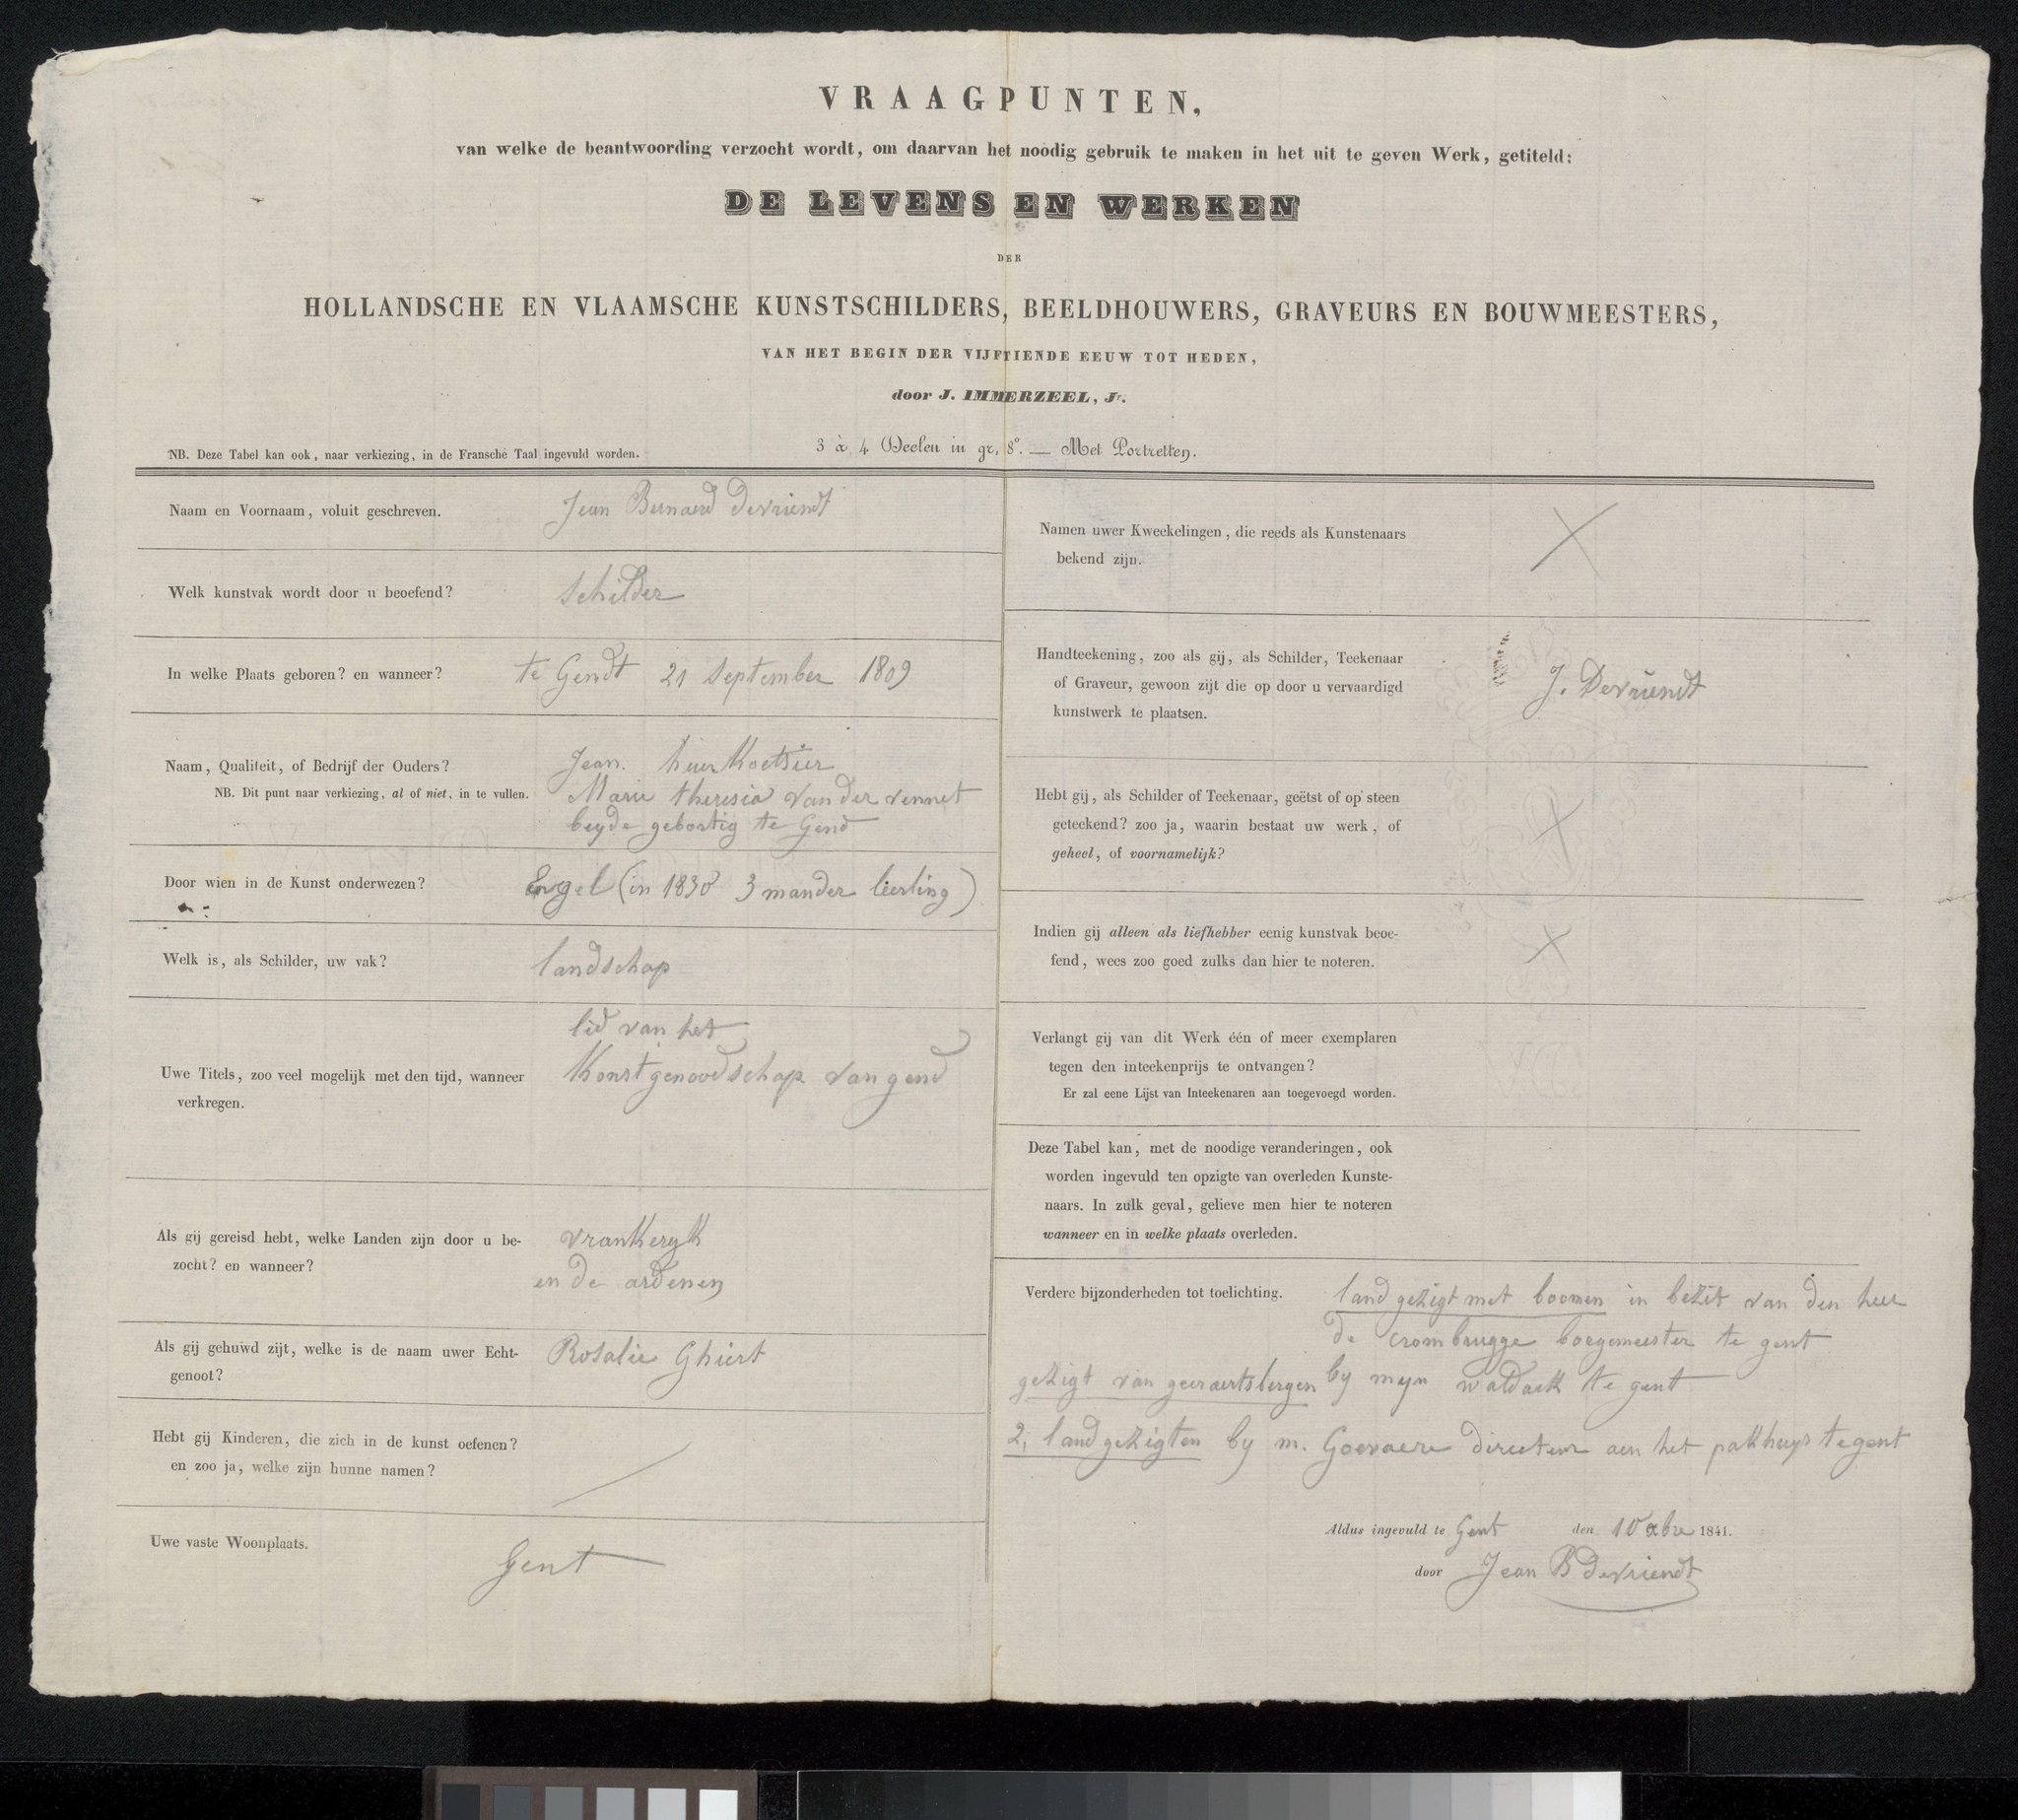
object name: manuscript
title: Enquêteformulier ingevuld door Jean Bernard De Vriendt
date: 1841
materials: paper, pencil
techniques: printing, writing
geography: ghent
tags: ghent, painter, jean bernard de vriendt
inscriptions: watermark, inscription: ‘Vraagpunten,/ van welke de beantwoording verzocht wordt, om daarvan het noodig gebruik te maken in het uit te geven Werk, getiteld: De levens en werken/ der Hollandsche en Vlaamsche kunstschilders, beeldhouwers,/ graveurs en bouwmeesters, van het begin der vijftiende eeuw tot heden/ door J. Immerzeel, Jr.’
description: Opgenomen in: Immerzeel, J. Jr., De levens en werken der Hollandsche en Vlaamsche kunstschilders, beeldhouwers, graveurs en bouwmeesters, van het begin der vijftiende eeuw tot heden, Amsterdam: J.C. van Kesteren, 1842-1843.